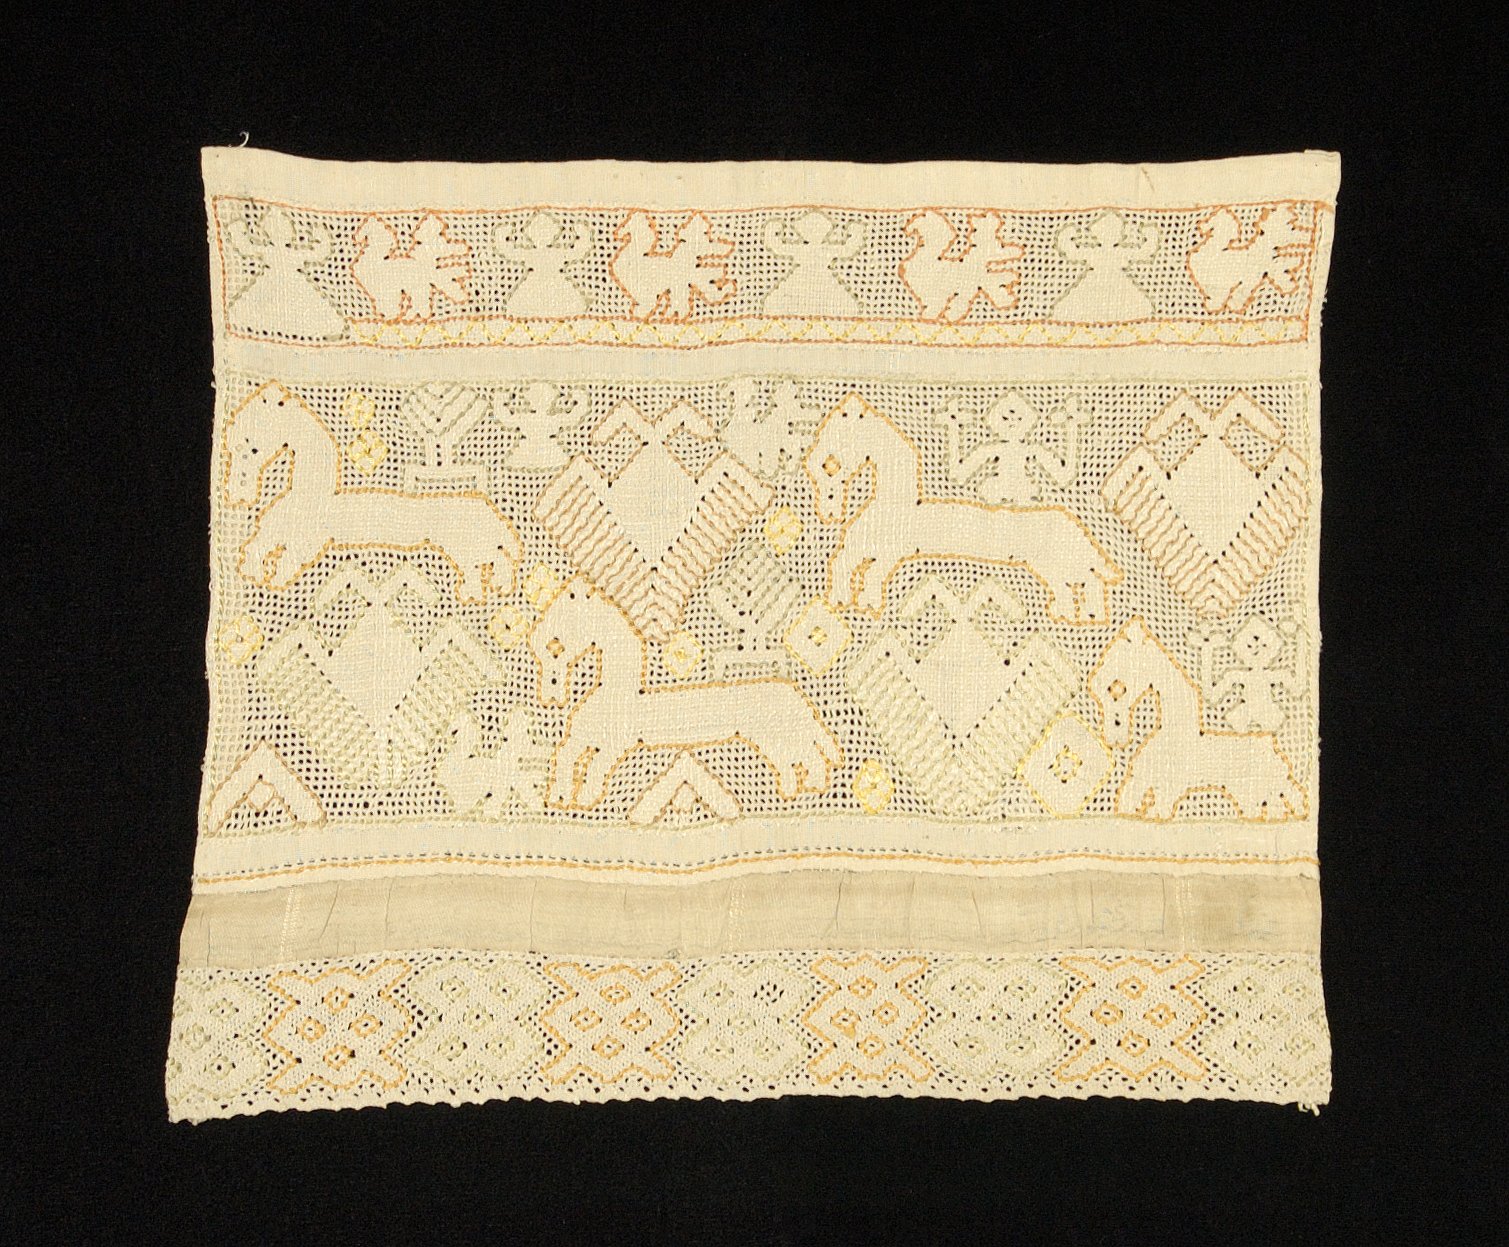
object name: border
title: Towel border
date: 1800-1850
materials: linen, silk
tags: human figures,animals